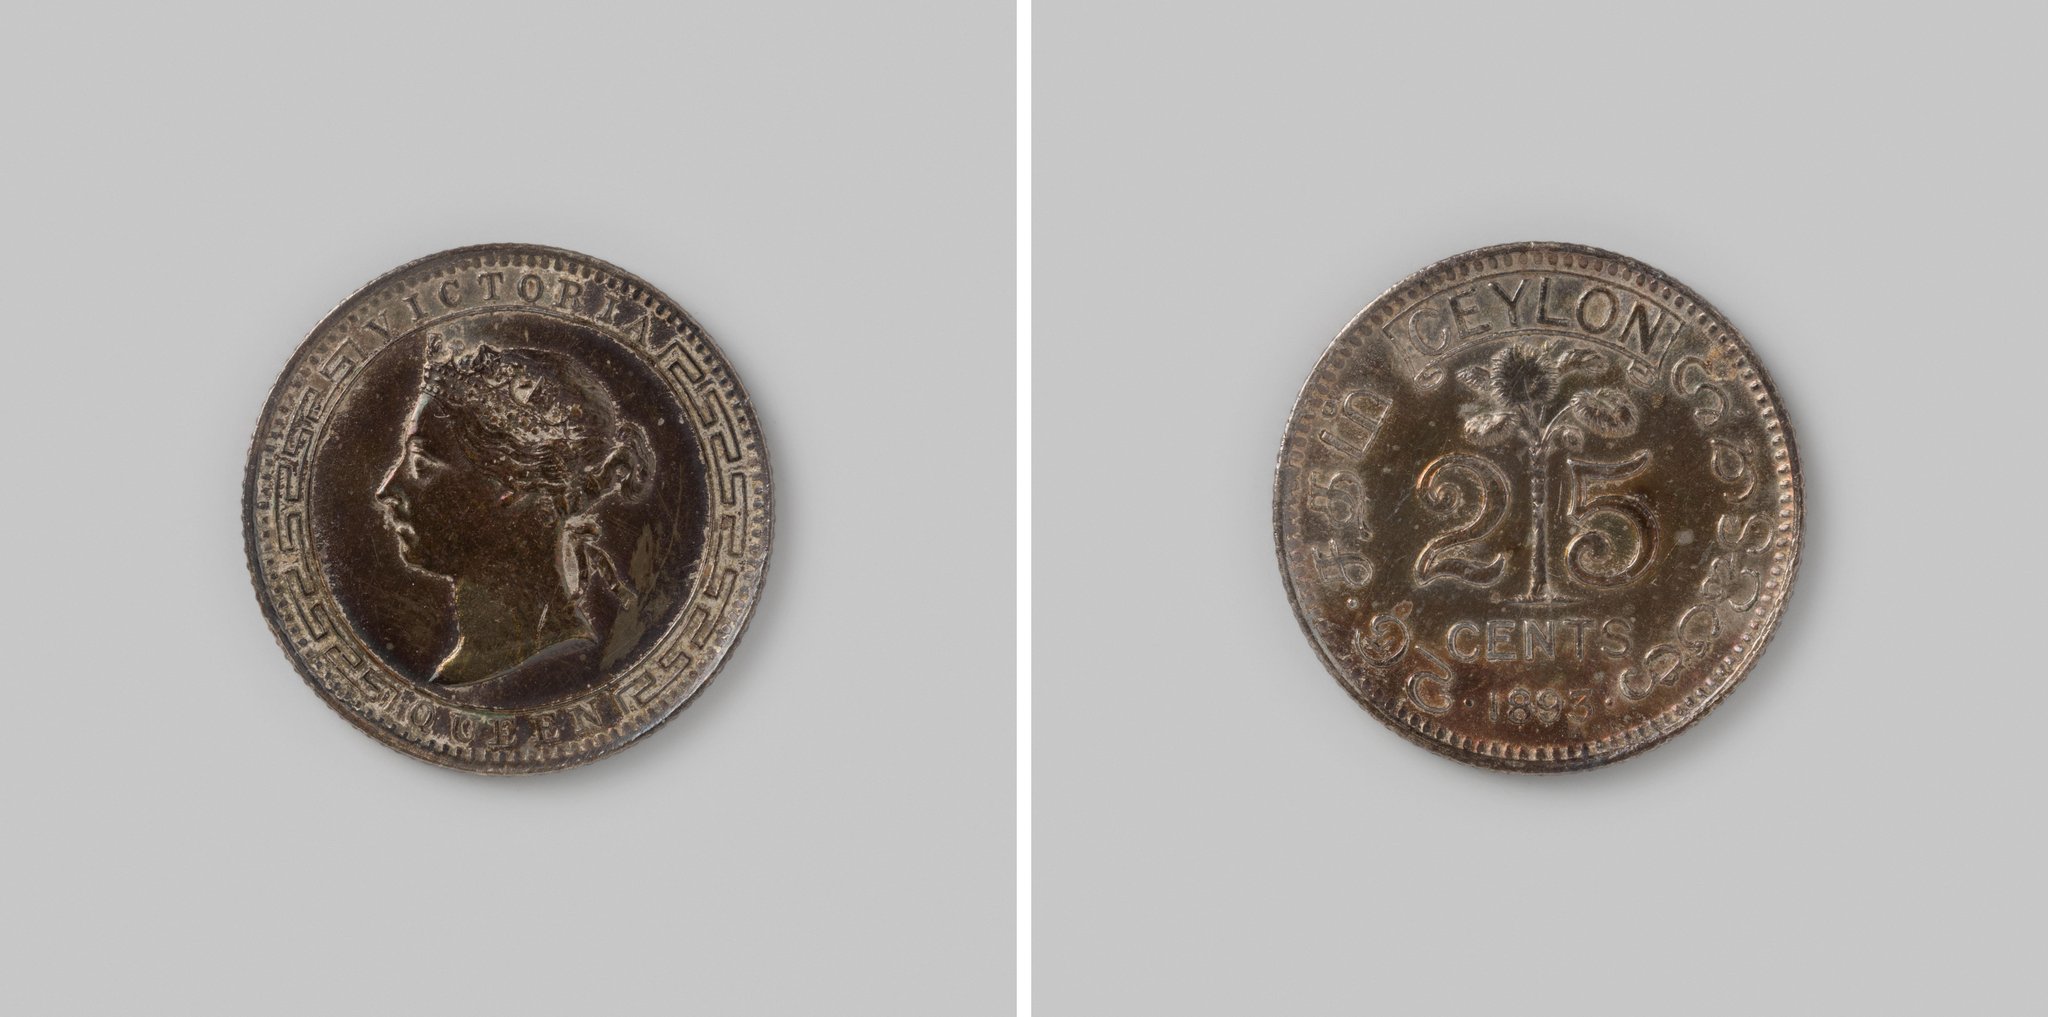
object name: coin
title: Sri Lanka, Ceylon, 25 cents op naam van koningin Victoria,1893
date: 1893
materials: silver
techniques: striking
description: Zilveren munt. Voorzijde: hoofd met diadeem van de koningin naar links. Keerzijde: tussen waarde-aanduiding - in twee regels - palmboom. Jaartal onderaan. Kartelrand.